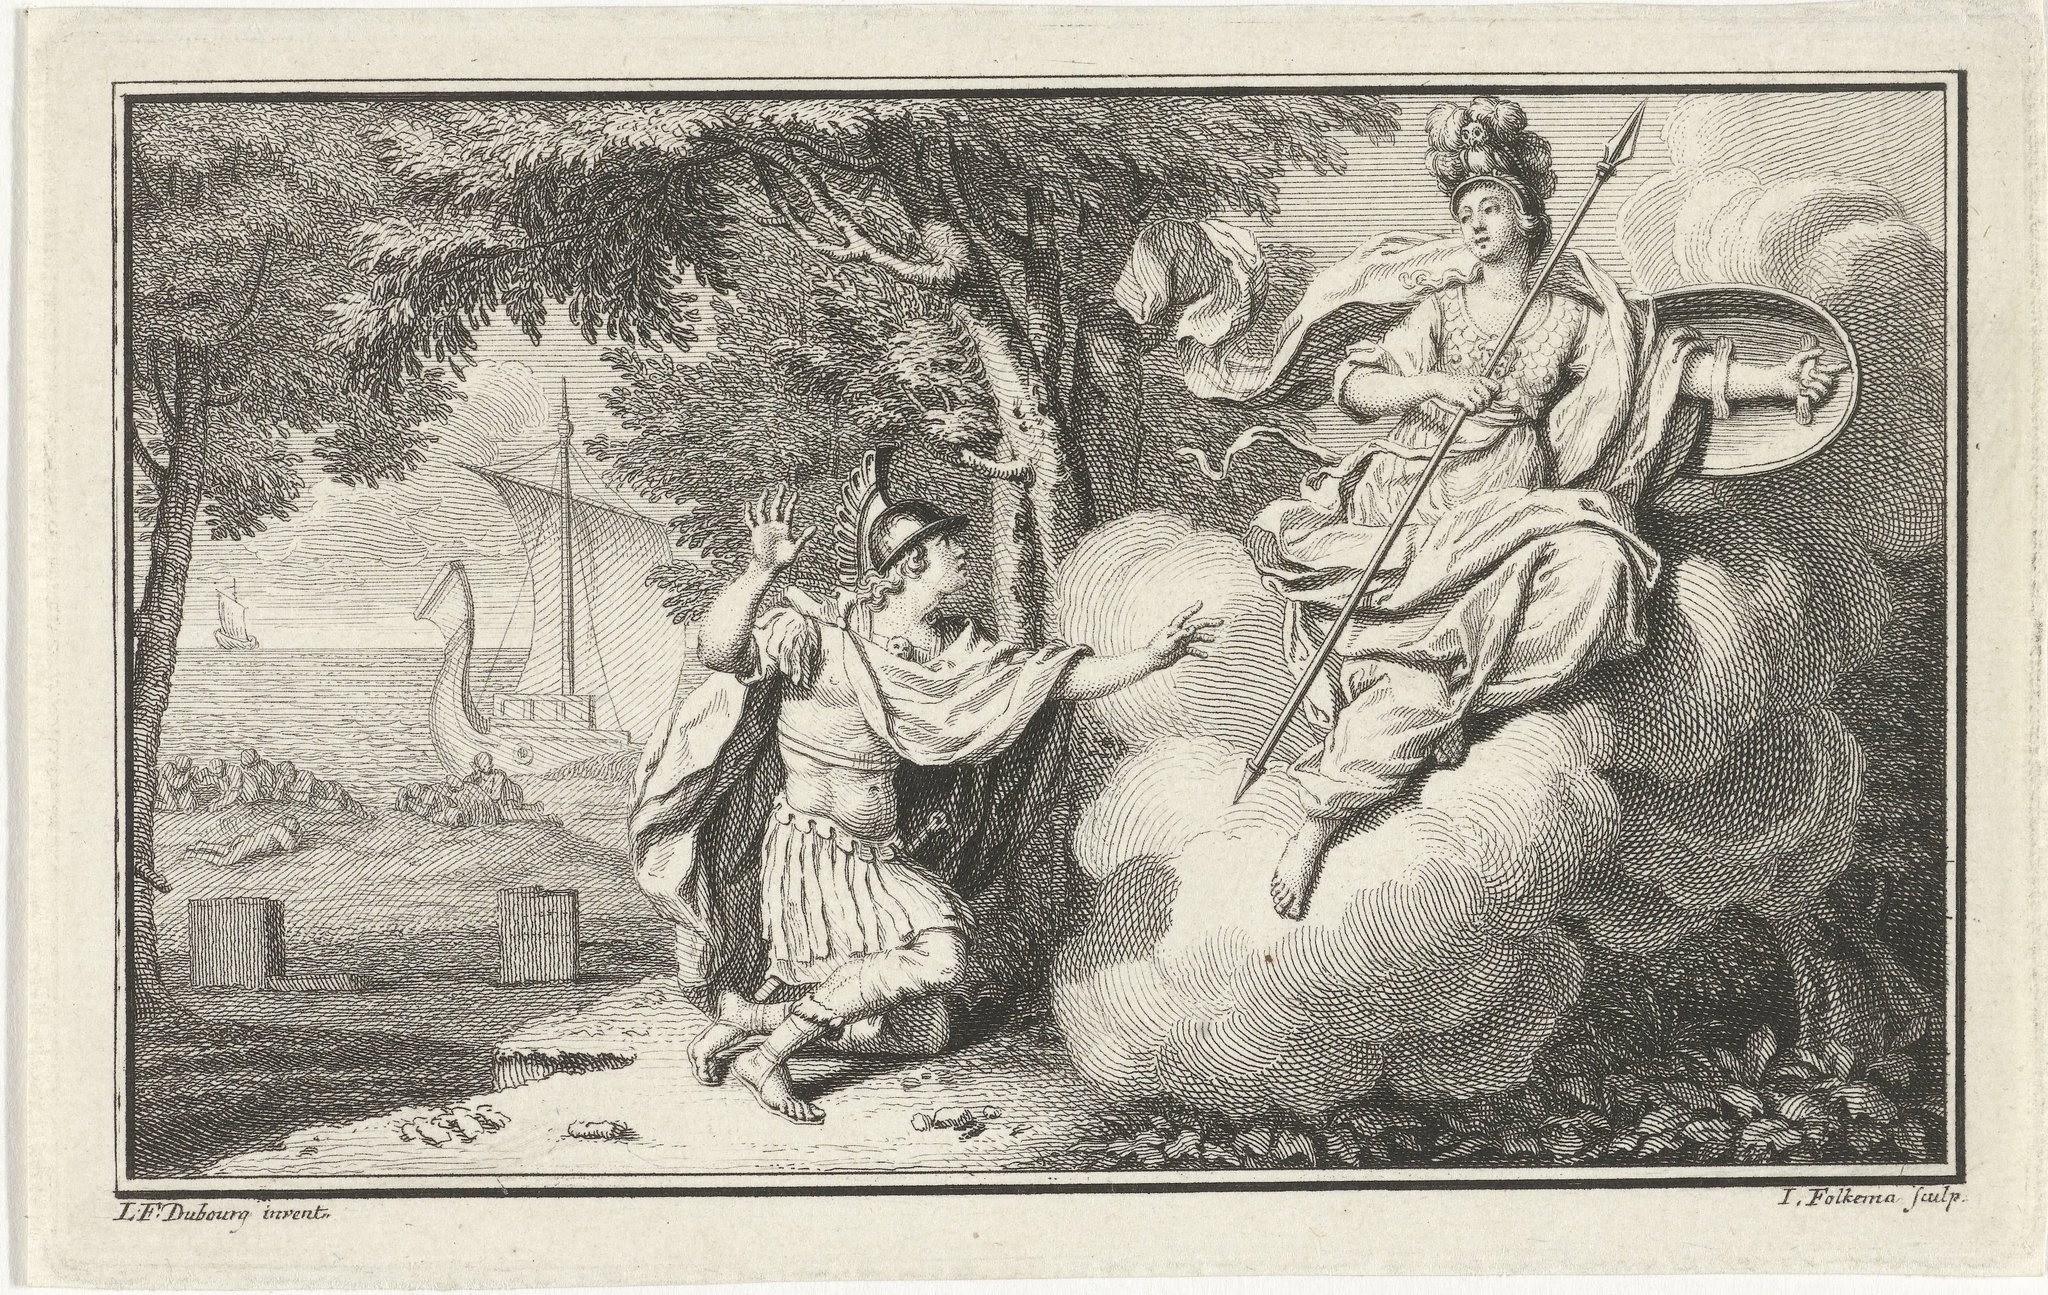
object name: print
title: Minerva en Telemachus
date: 1703-1767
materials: paper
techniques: etching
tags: (story of) minerva (pallas, athena), drowning, shipwrecked person, shipwreck, (story of) telemachus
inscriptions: collector's mark: Lugt 240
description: Minerva verdwijnt achter de wolken en kijkt hierbij naar de geknielde Telemachus. Op de achtergrond zicht op een gestrand schip, op het strand liggen drenkelingen.